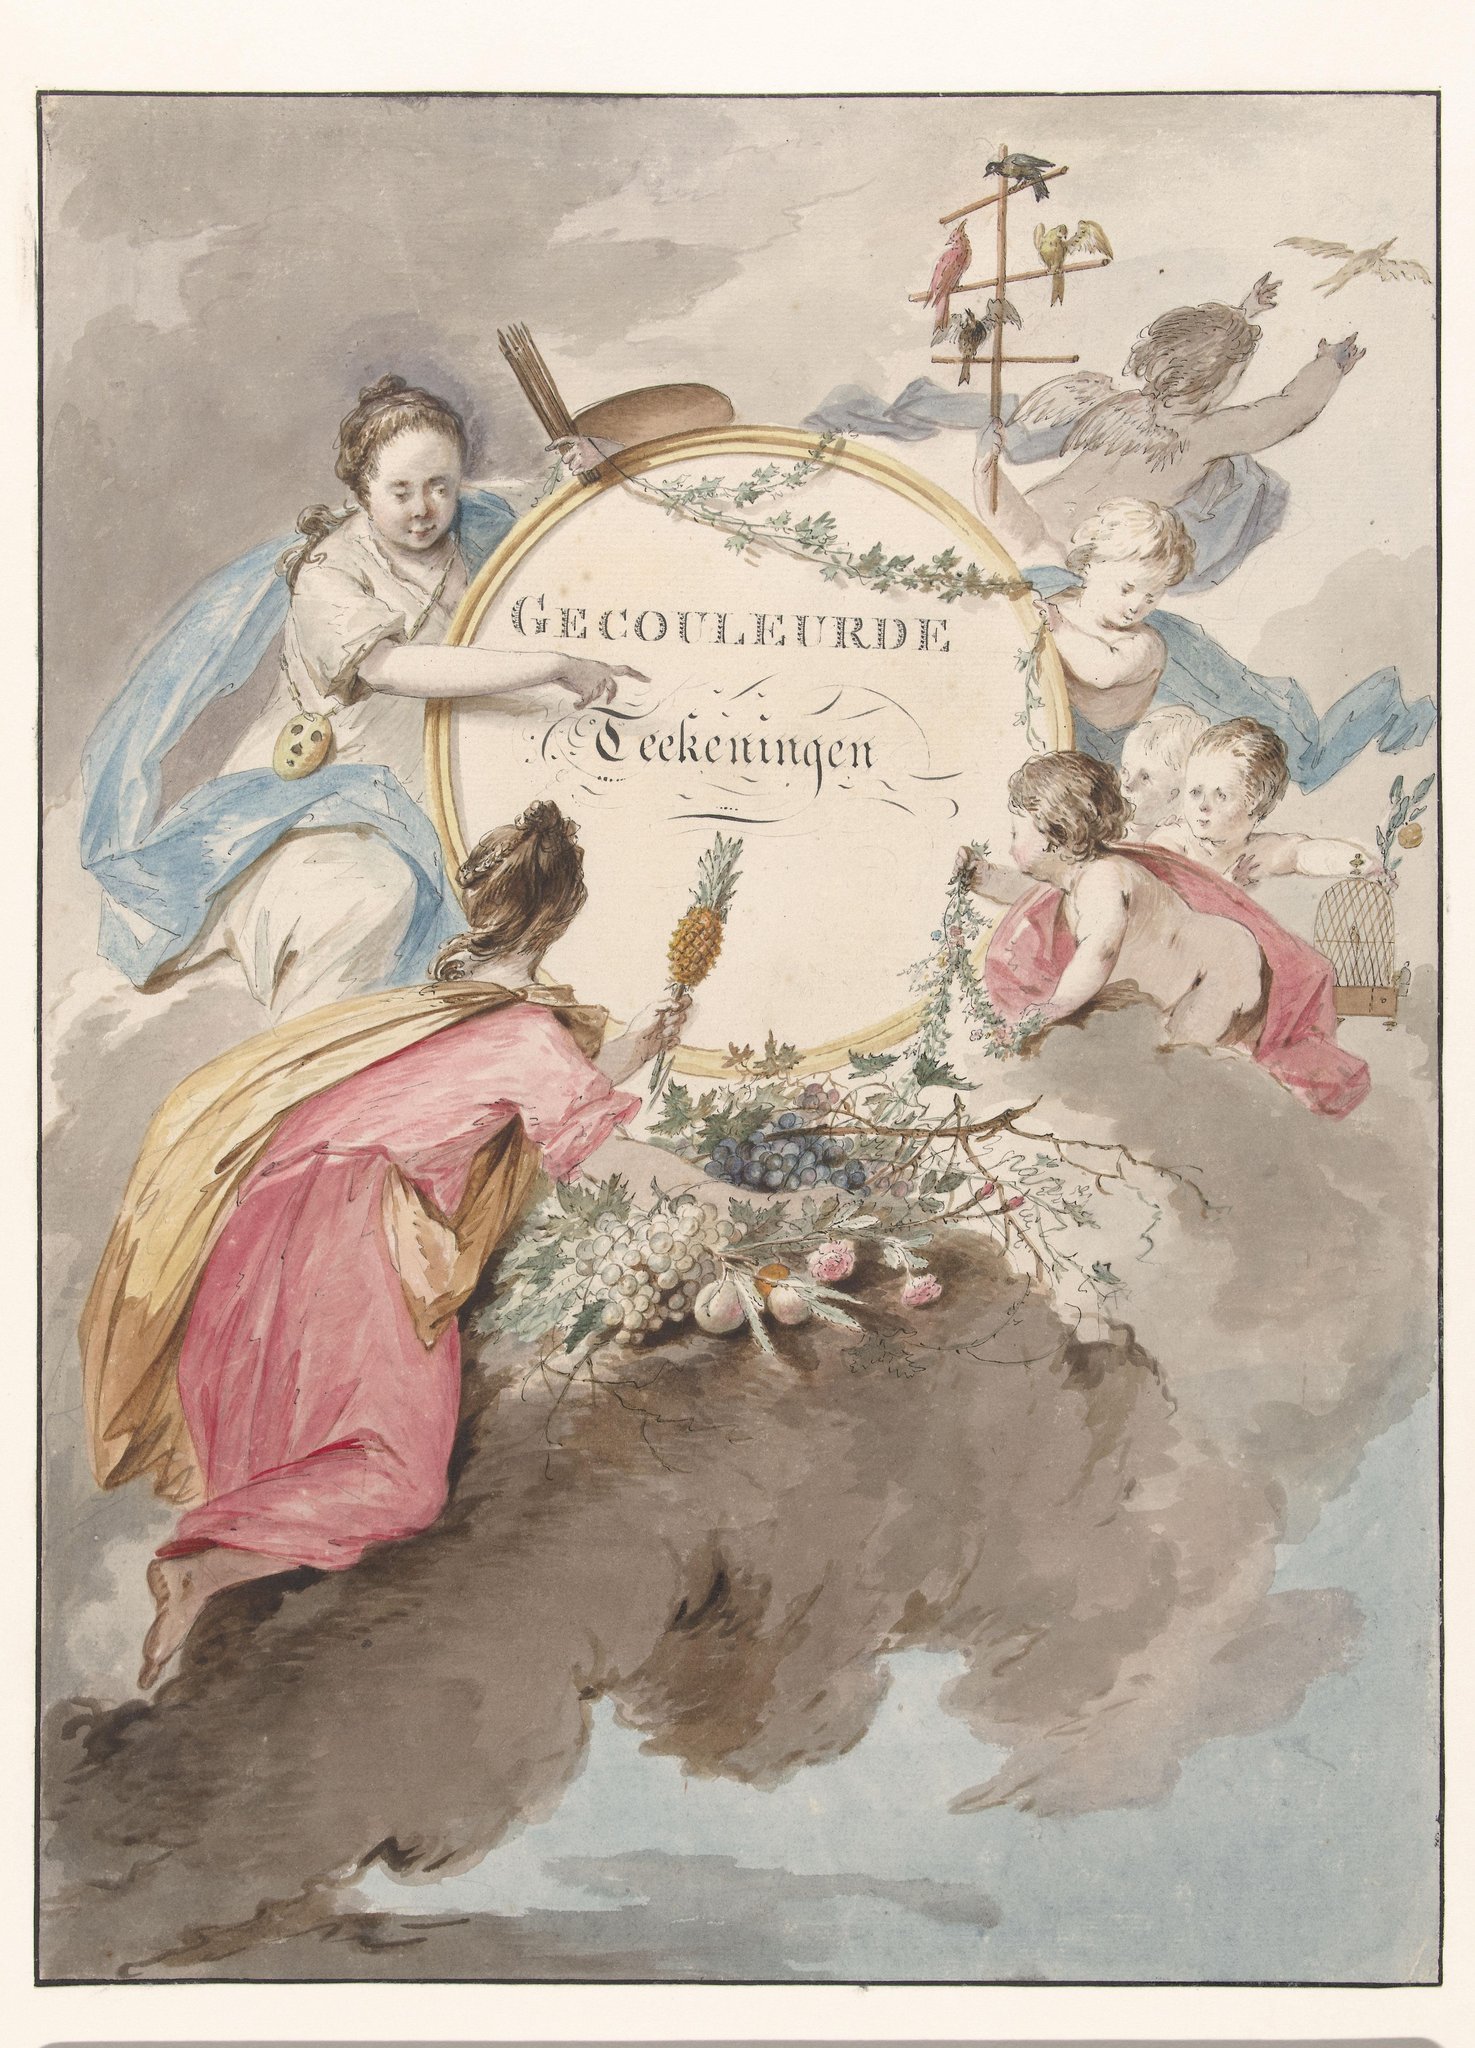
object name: watercolor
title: Titelblad voor kunstboek met Gecouleurde Teekeningen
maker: gerard van nijmegen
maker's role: draughtsman, painter, print maker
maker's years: 1735-1808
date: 1745-1808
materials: chalk, ink, paper, watercolor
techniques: brush, pen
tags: 'pictura', symbolic representations, allegories and emblems ~ painting; 'pittura' (ripa)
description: Ronde cartouche met titel, waaromheen vrouwenfiguren en putti.